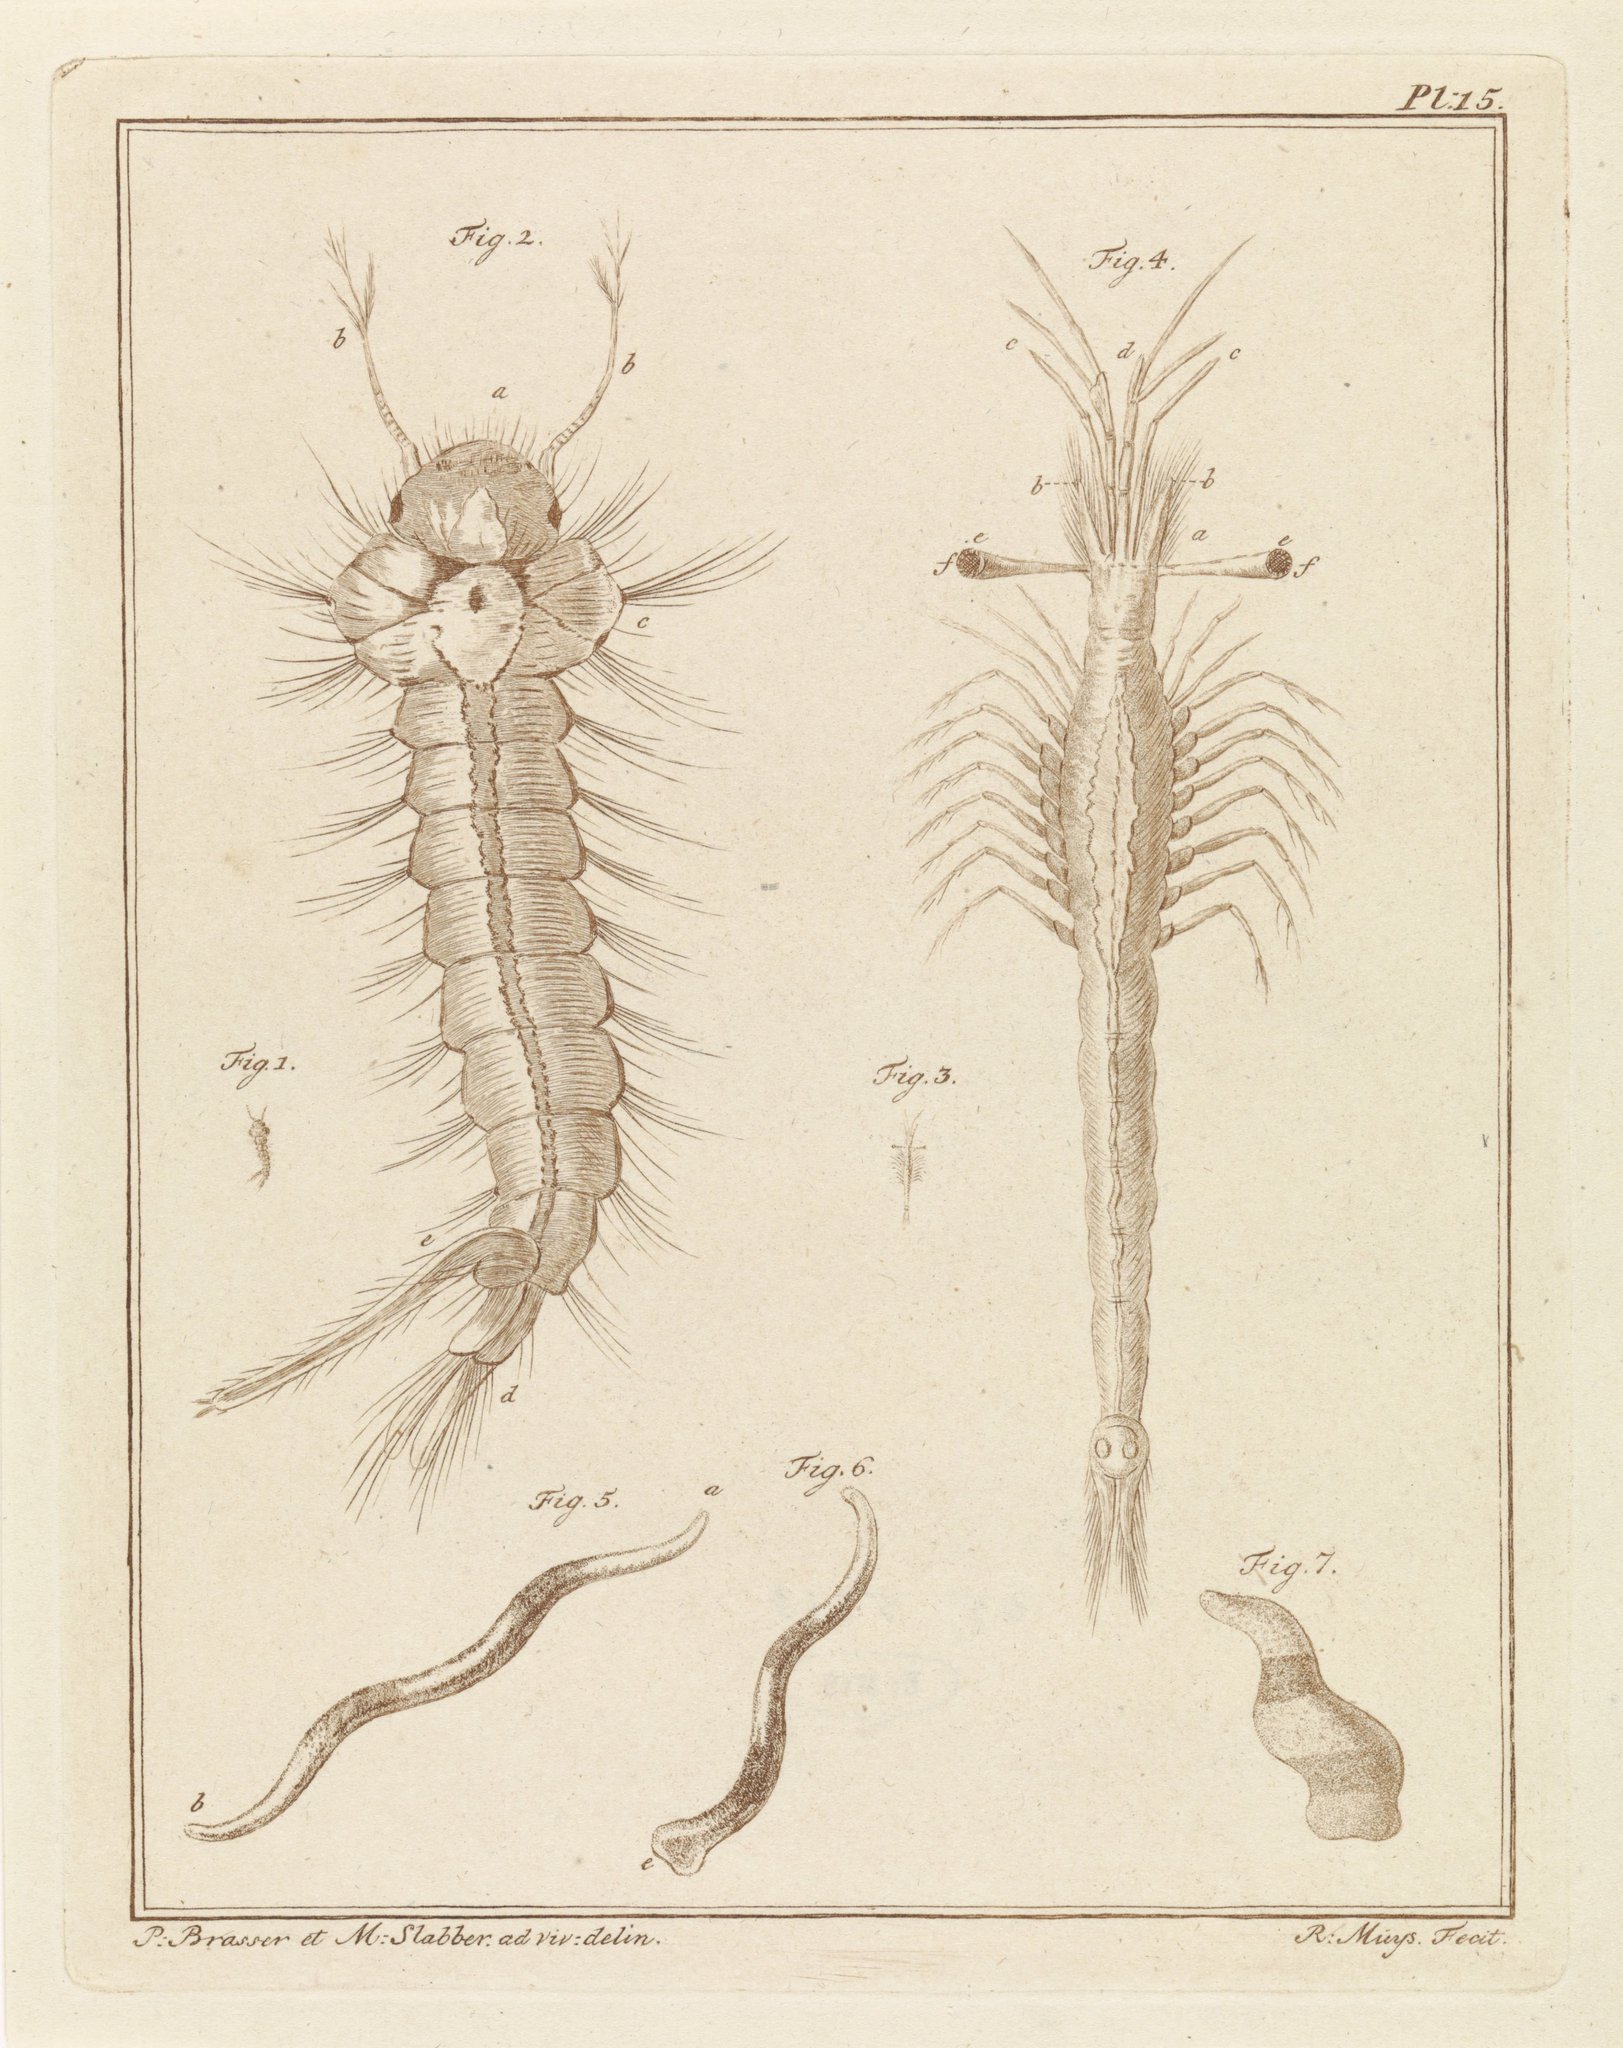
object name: book illustration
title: Steekmug, Slabbers trompetoog en een worm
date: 1778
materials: paper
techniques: etching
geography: rotterdam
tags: lower animals (+ animals ~ biological investigation)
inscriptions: collector's mark: Lugt 2228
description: Figuur 1 en 2 tonen een steekmug. Figuur 2 en 3 tonen Slabbers trompetoog op ware grootte en uitvergroot. Figuur 5, 6 en 7 tonen een worm. Rechtsboven: Pl. 15. Prent uit een boek over binnen- en buitenlandse land- en waterdieren.